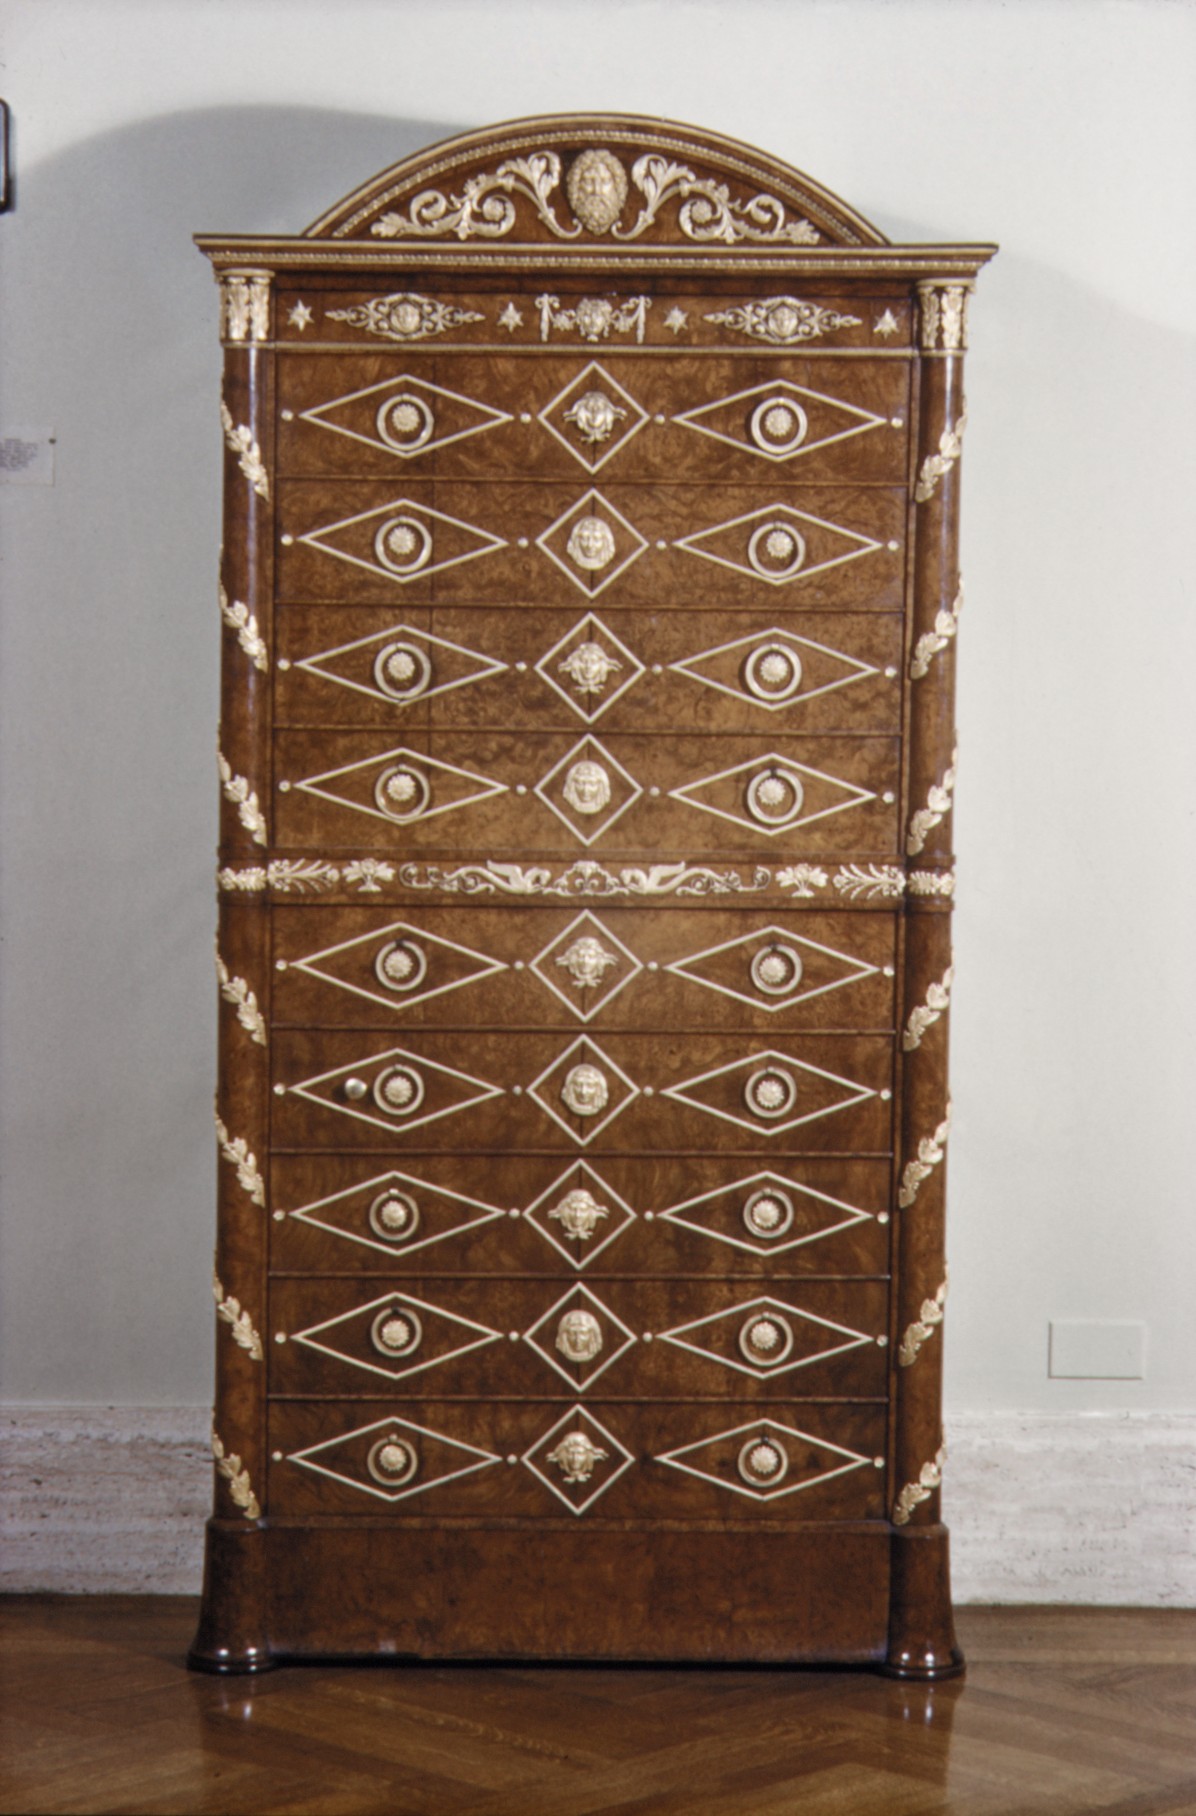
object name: secretary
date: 1804-1809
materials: gilt bronze, wood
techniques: veneering